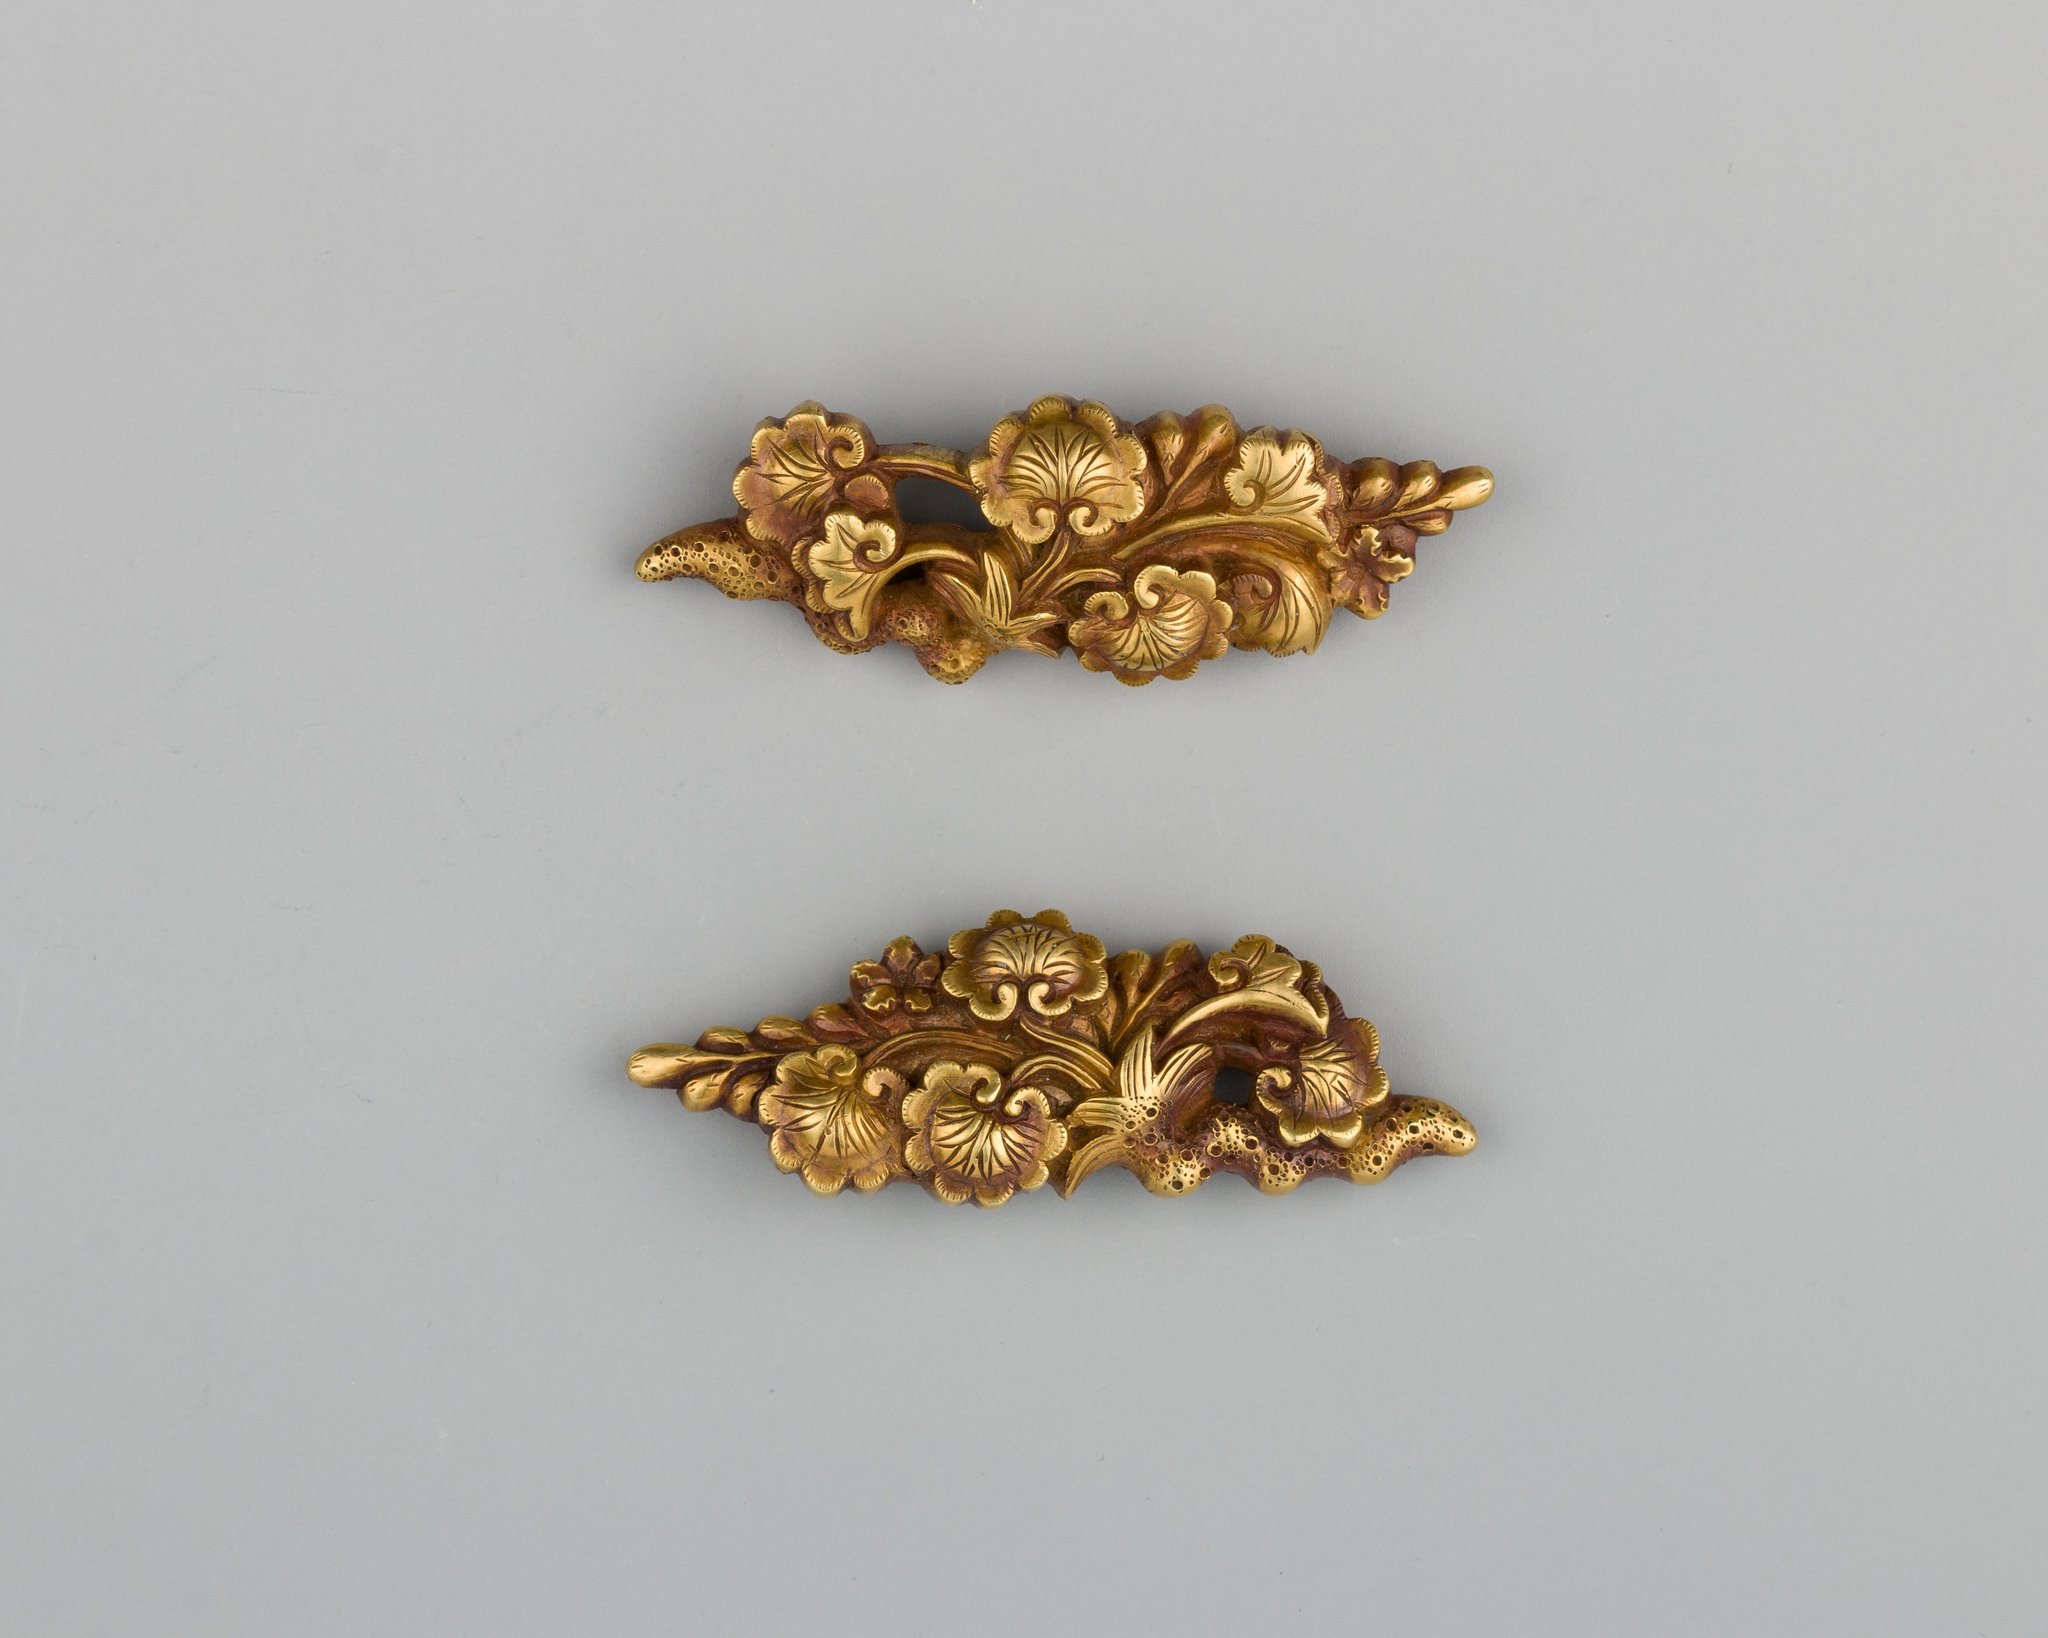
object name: pair of sword grip ornament menuki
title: Pair of Sword-Grip Ornaments (Menuki)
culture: japanese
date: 1701-1800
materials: gold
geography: japan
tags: flowers